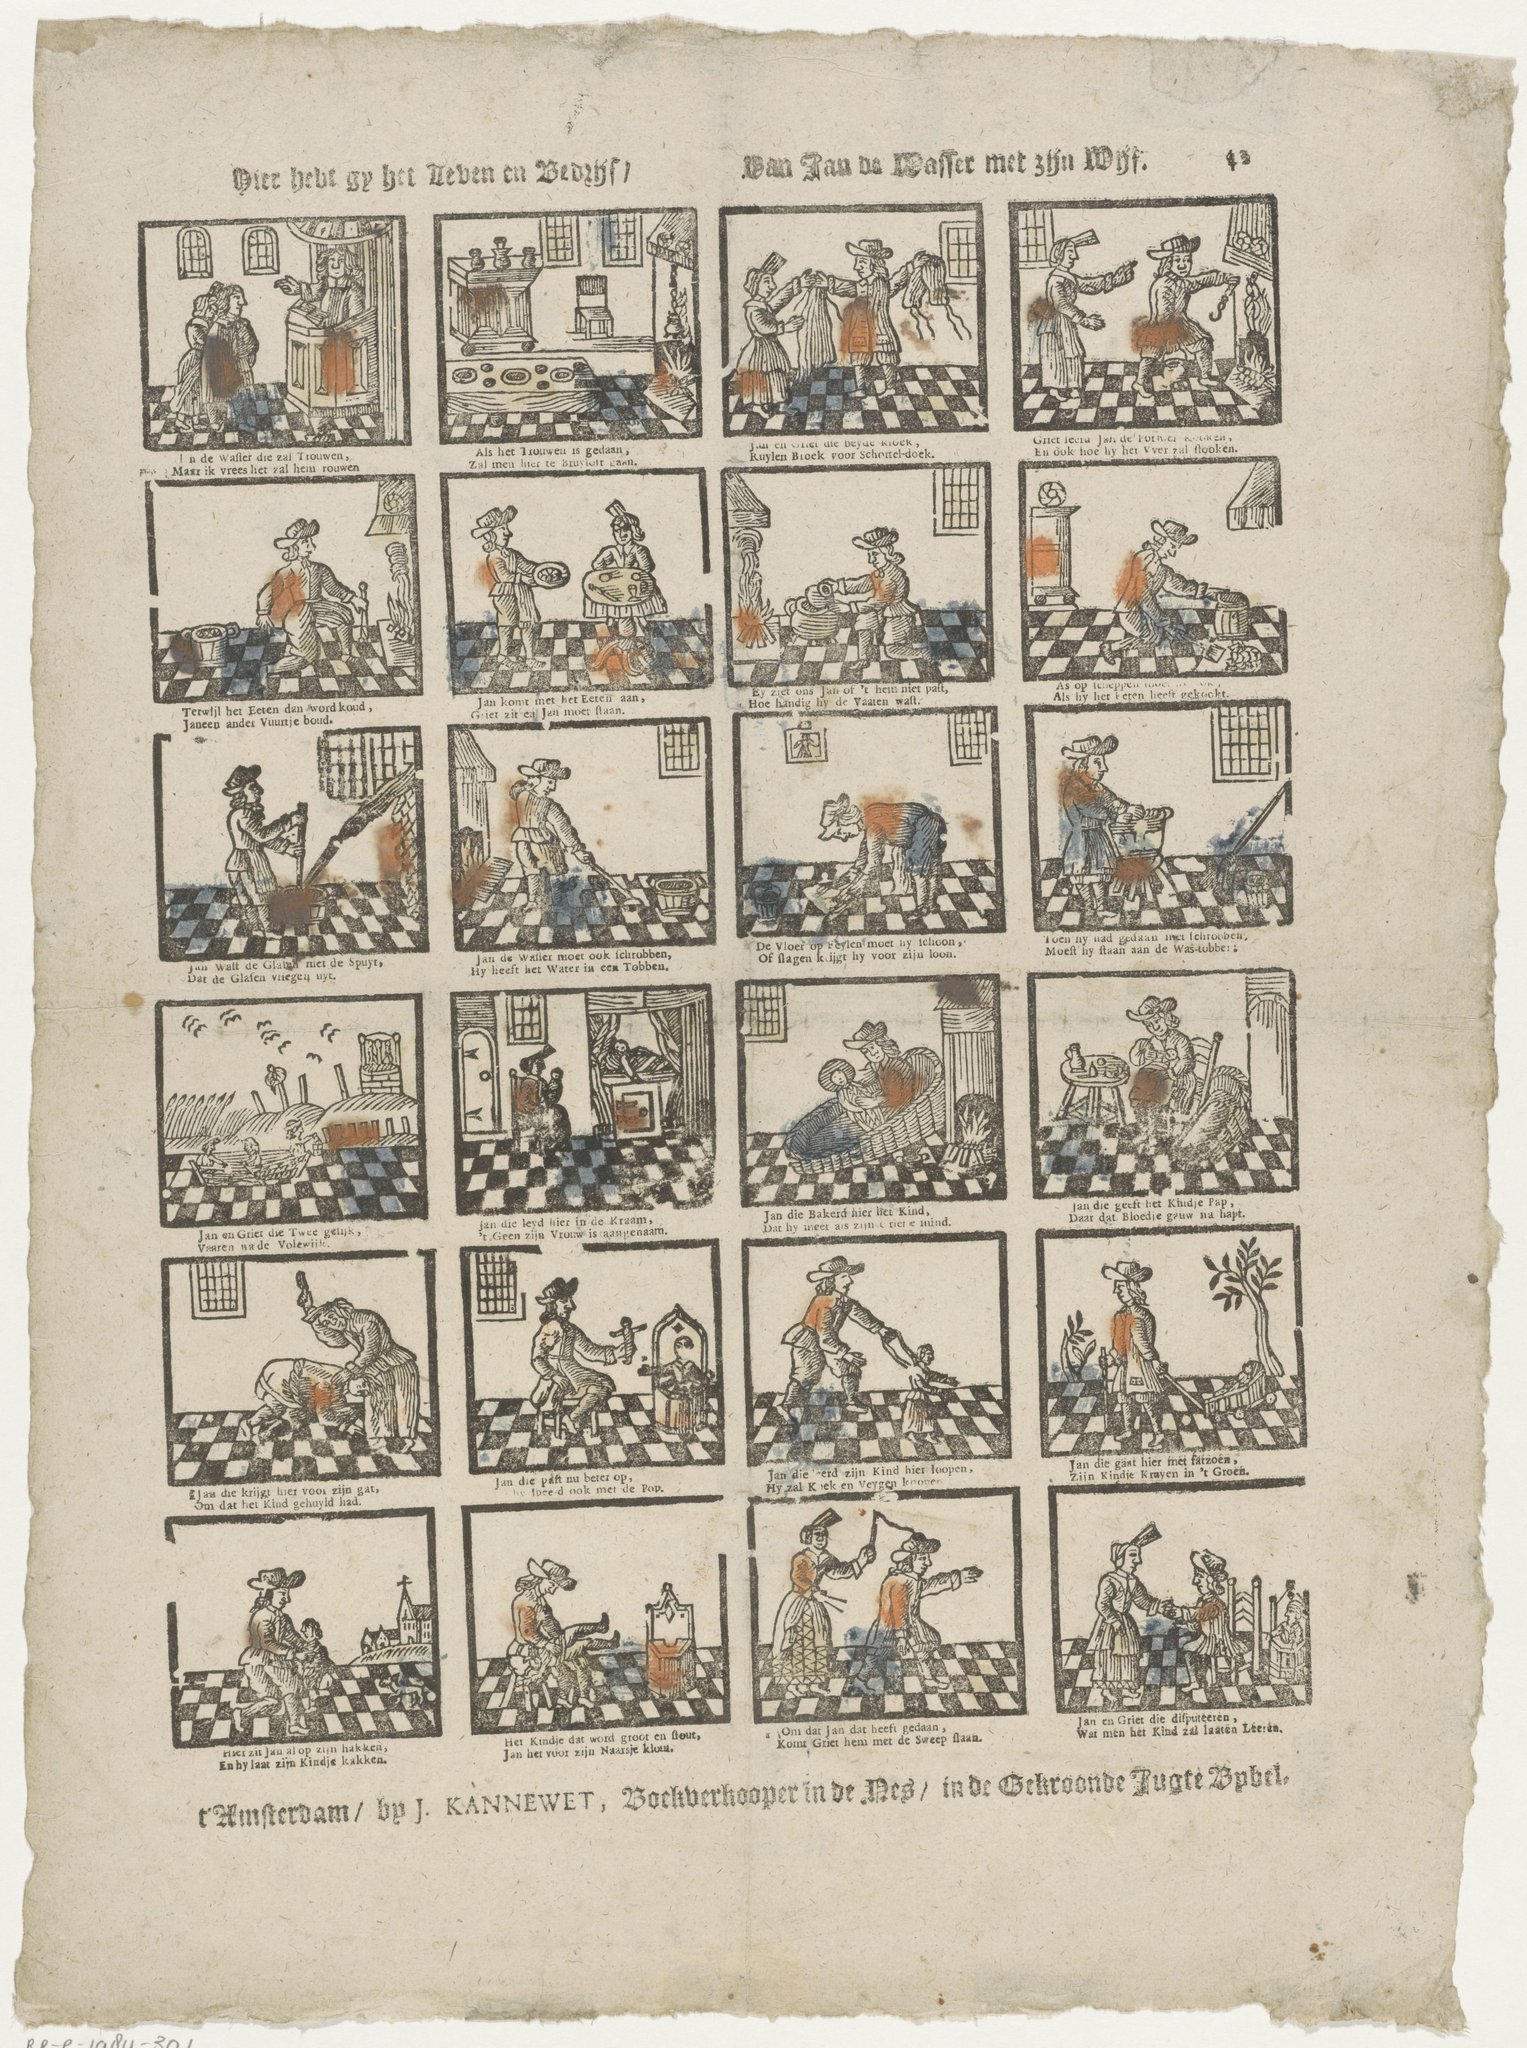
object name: popular print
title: Hier hebt gy het leven en bedrijf / Van Jan de Wasser en zijn wijf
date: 1725-1780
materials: paper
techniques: colour, letterpress printing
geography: amsterdam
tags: hen-pecked husband, 'betty', 'molly' (man who engages in women's work)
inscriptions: collector's mark: Lugt 2760, collector's mark: Lugt 2228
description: Blad met 24 voorstellingen uit het leven van Jan de Wasser, een man die van zijn vrouw Griet, die de broek aan heeft, al het huishoudelijk werk moet doen. Onder elke afbeelding een tweeregelig vers. Genummerd rechtsboven: 42.